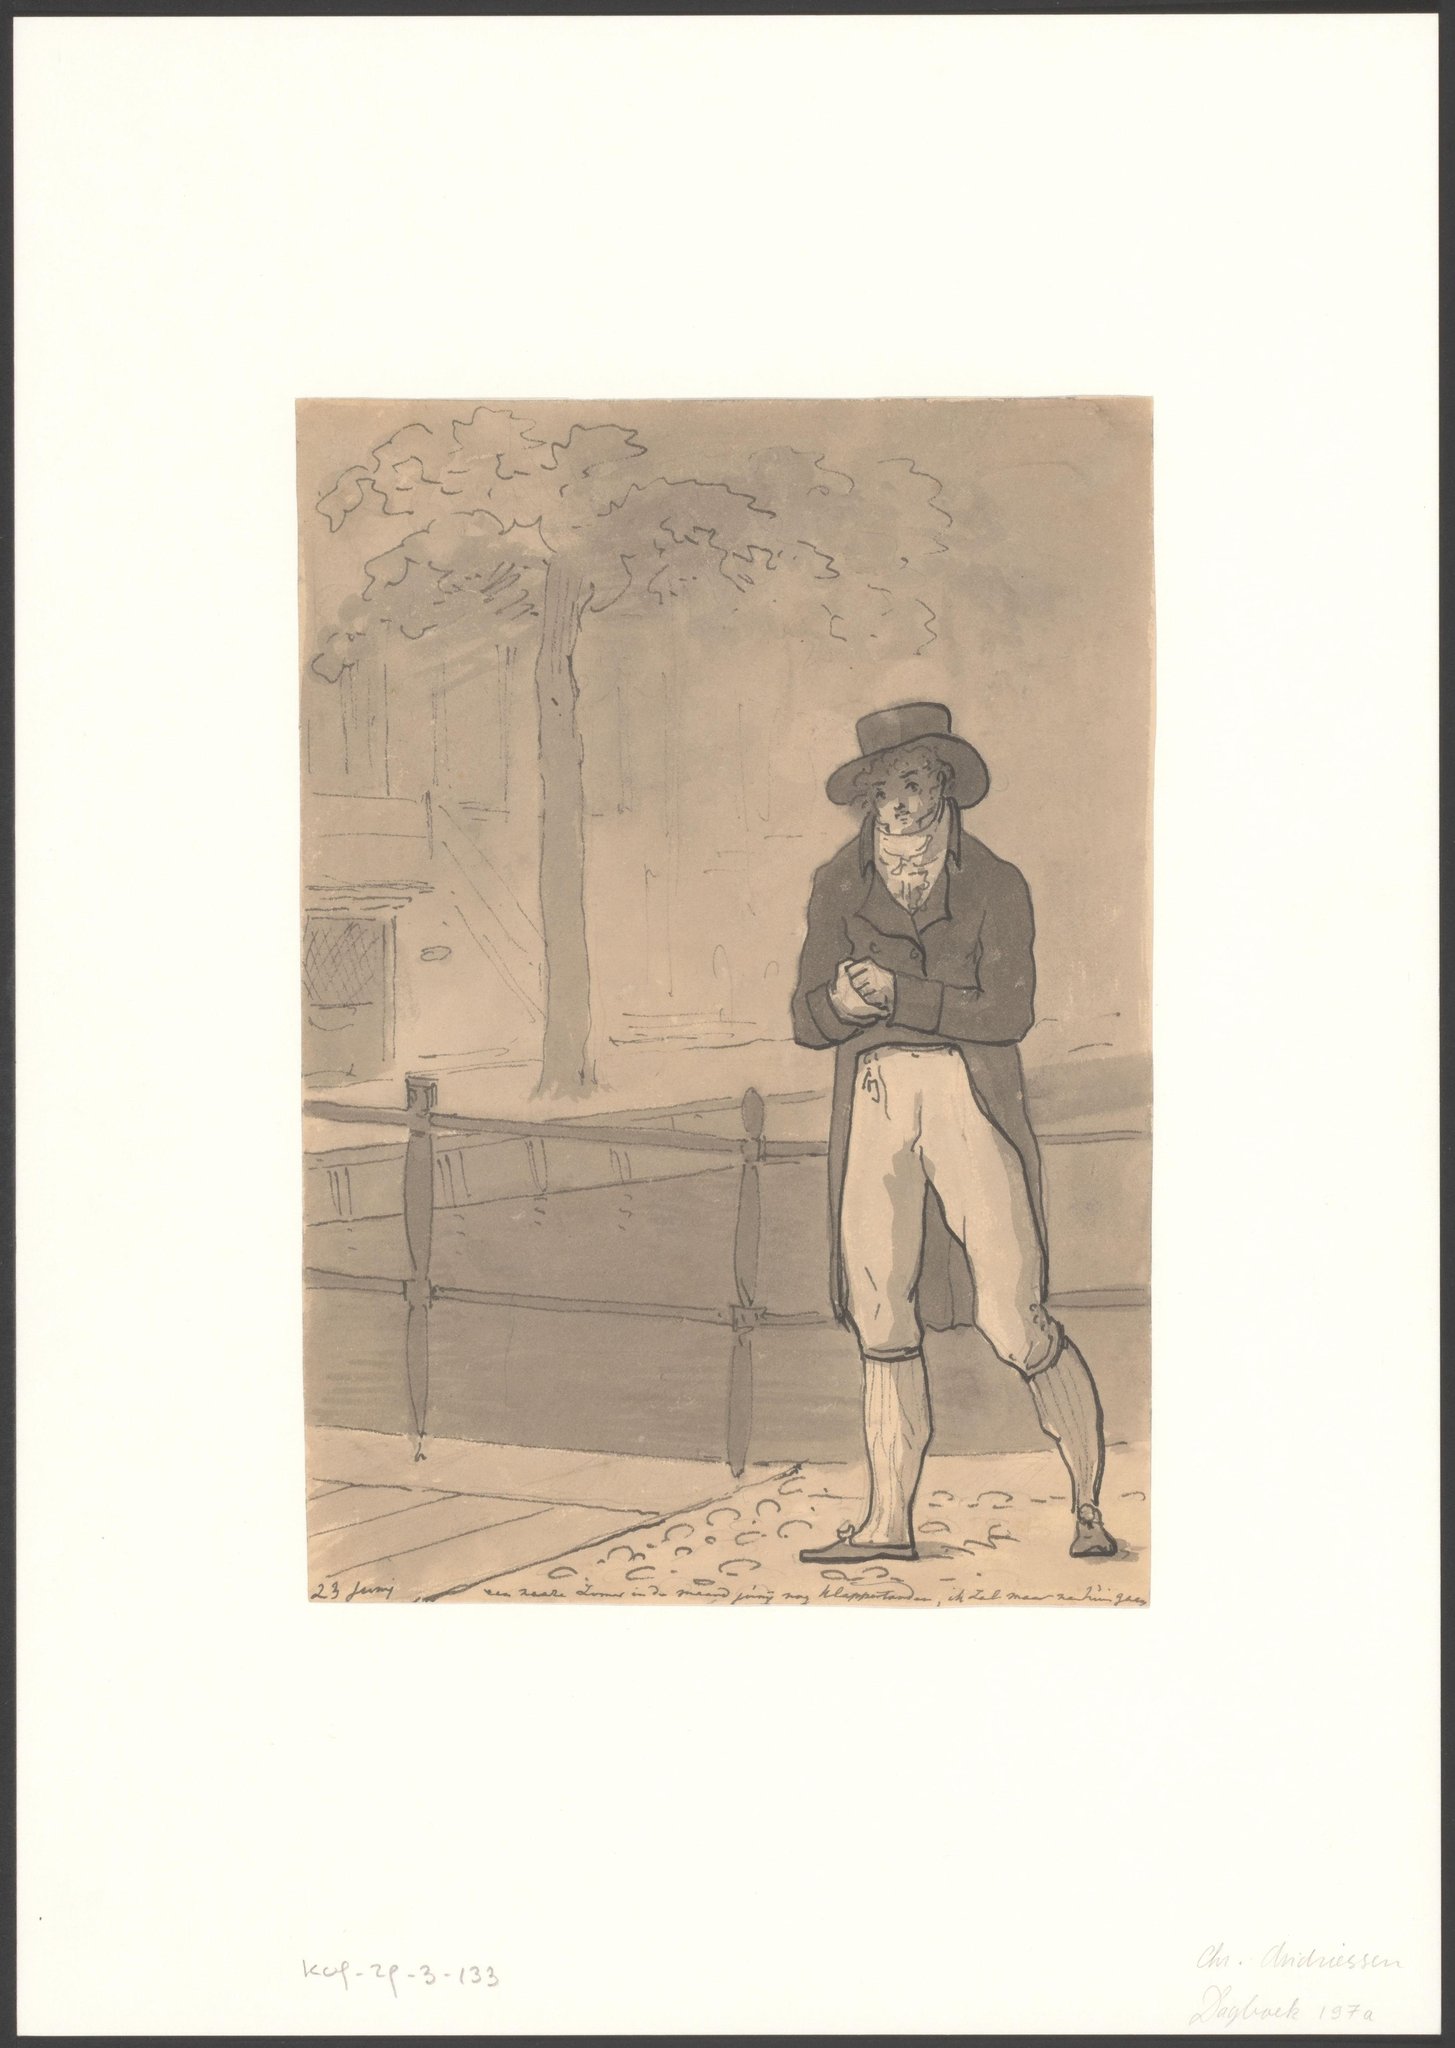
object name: print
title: Christiaan Andriessen met hoge hoed bij een brug wrijft zijn handen samen op een koude juni dag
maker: christiaan andriessen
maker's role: draughtsman, print maker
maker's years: 1775-1846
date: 1805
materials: ink, paper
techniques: brush, pen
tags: amsterdam, print maker, draughtsman, christiaan andriessen, coldness, bridge, head-gear: top hat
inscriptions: inscription: ‘23 junij een naare Zomer in de maand junij nog klappertanden ik zal maar naar huis gaan’, signature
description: Dagboekblad uit het getekende dagboek dat Christiaan Andriessen bijhield van 1805 tot en met 1808.